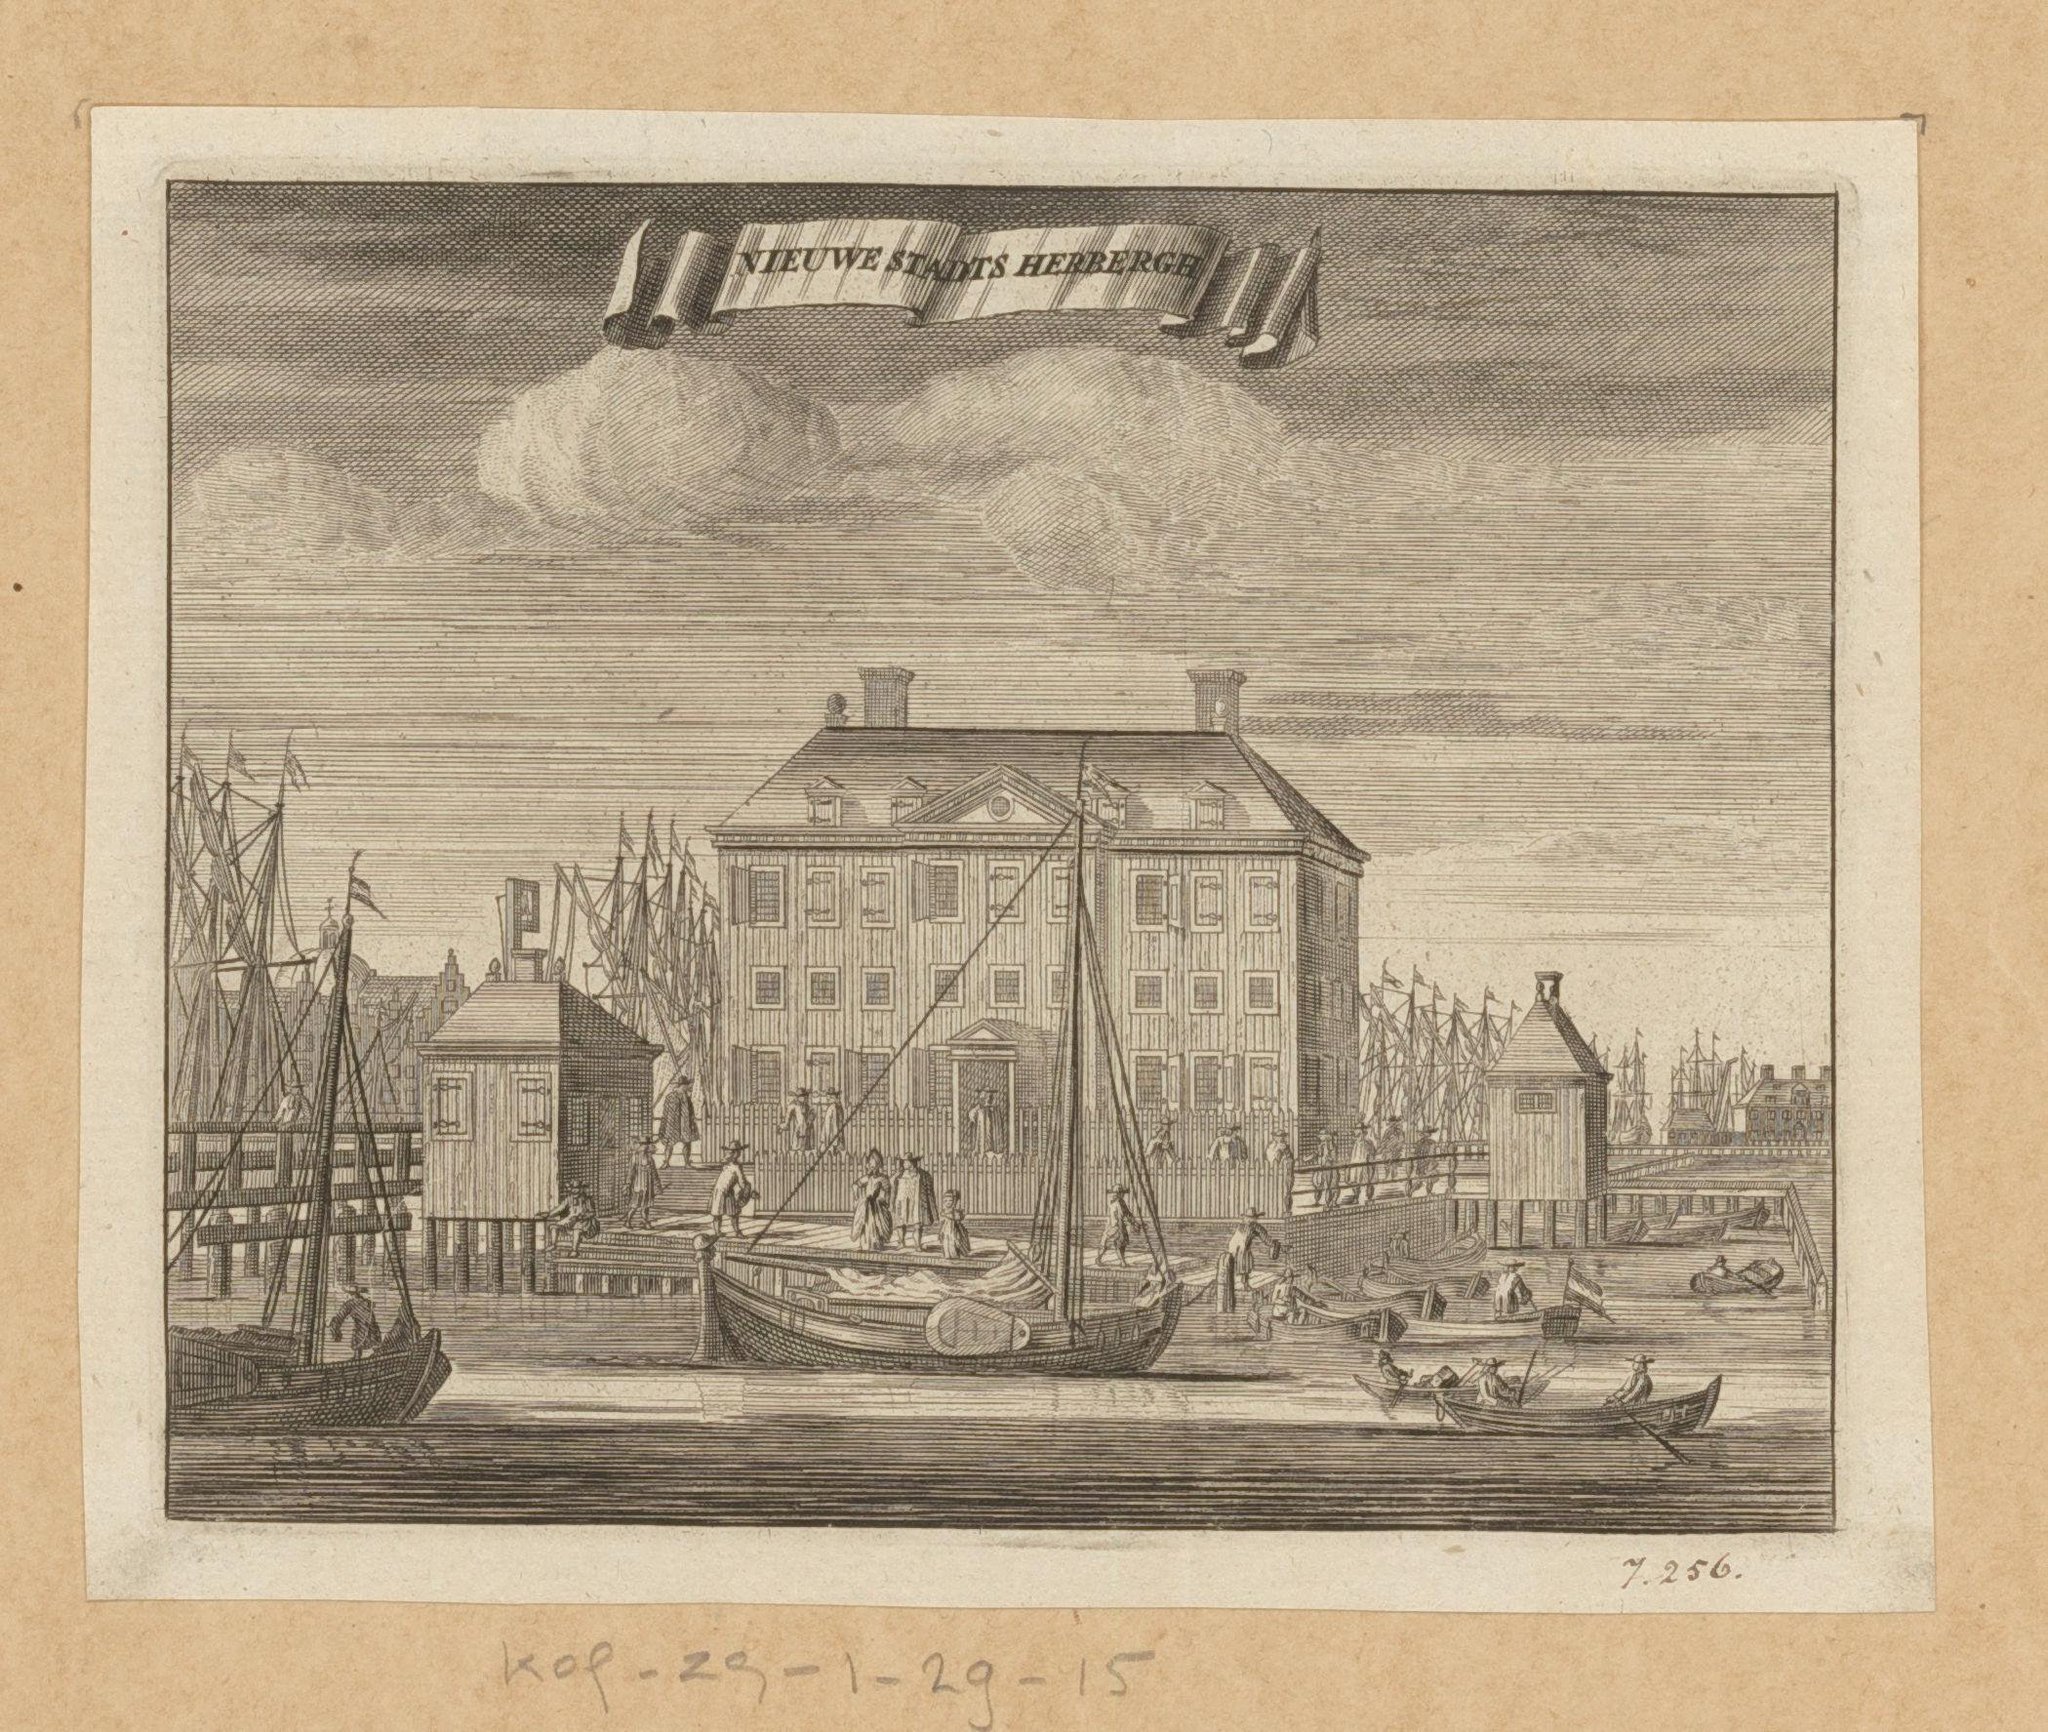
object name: print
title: Nieuwe Stadts herberg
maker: Anonymous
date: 1693-1694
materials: paper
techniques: engraving, etching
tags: pier, quay, wharf, hotel, hostelry, inn, amsterdam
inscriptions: stamp, stamp, collector's mark: Lugt 1641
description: Huidige staat van prent ook gebruikt in: Commelin, Caspar. Beschryvinge van Amsterdam, desselfs eerste oorspronk uyt den Huyse (…). 2 delen. Amsterdam: Abraham Wolfgang, Gillis Janssonius van Waesberge, Johannes Janssonius van Waesberge II, weduwe Dirk Boom I, Hendrick Boom en Rembertus Goethals, 1693. En in: Commelin, Caspar. Beschryvinge van Amsterdam, zynde een naukeurige verhandelinge van desselfs eerste oorspronk uyt (…). 2 delen. Amsterdam: weduwe Aart Dircksz Oossaan, 1694. Latere staat ook gebruikt in: Commelin, Caspar. Beschryvinge van Amsterdam, zynde een naukeurige verhandelinge van desselfs eerste oorspronk uyt (…). 2 delen. 2e druk. Amsterdam: Andries van Damme, Johannes Ratelband, weduwe A. van Aaltwyk en Hermanus Uytwerf, 1726.